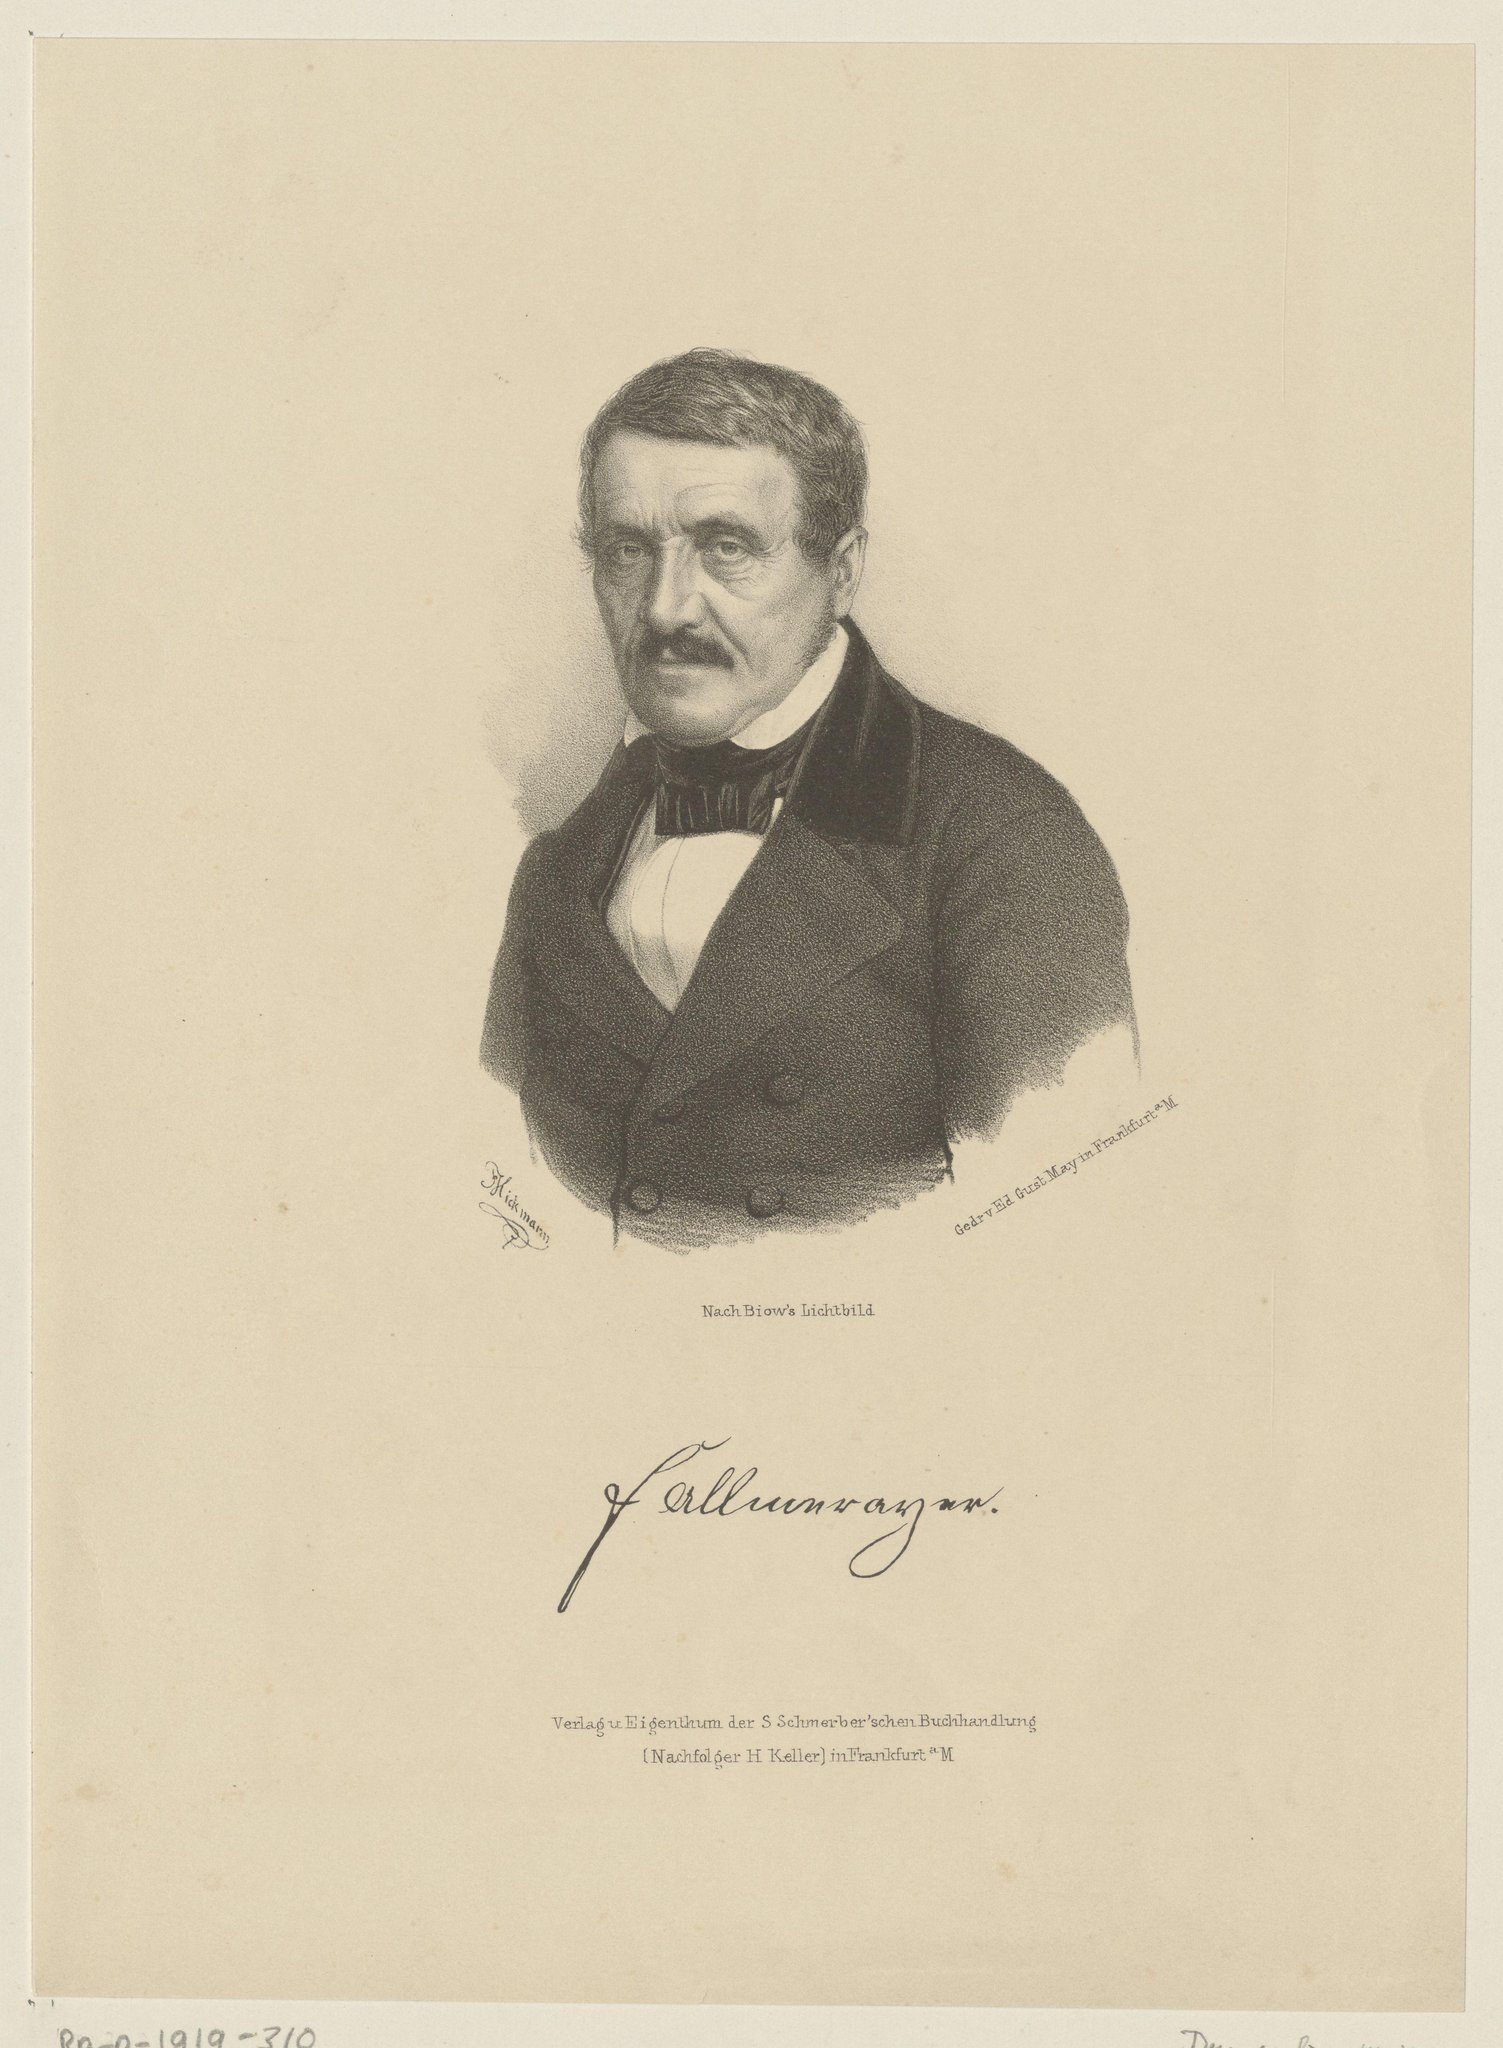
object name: print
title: Portret van Jakob Philipp Fallmerayer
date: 1840-1860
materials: paper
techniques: lithograph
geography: frankfurt am main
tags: historical persons, portrait of a writer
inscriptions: collector's mark: Lugt 2228